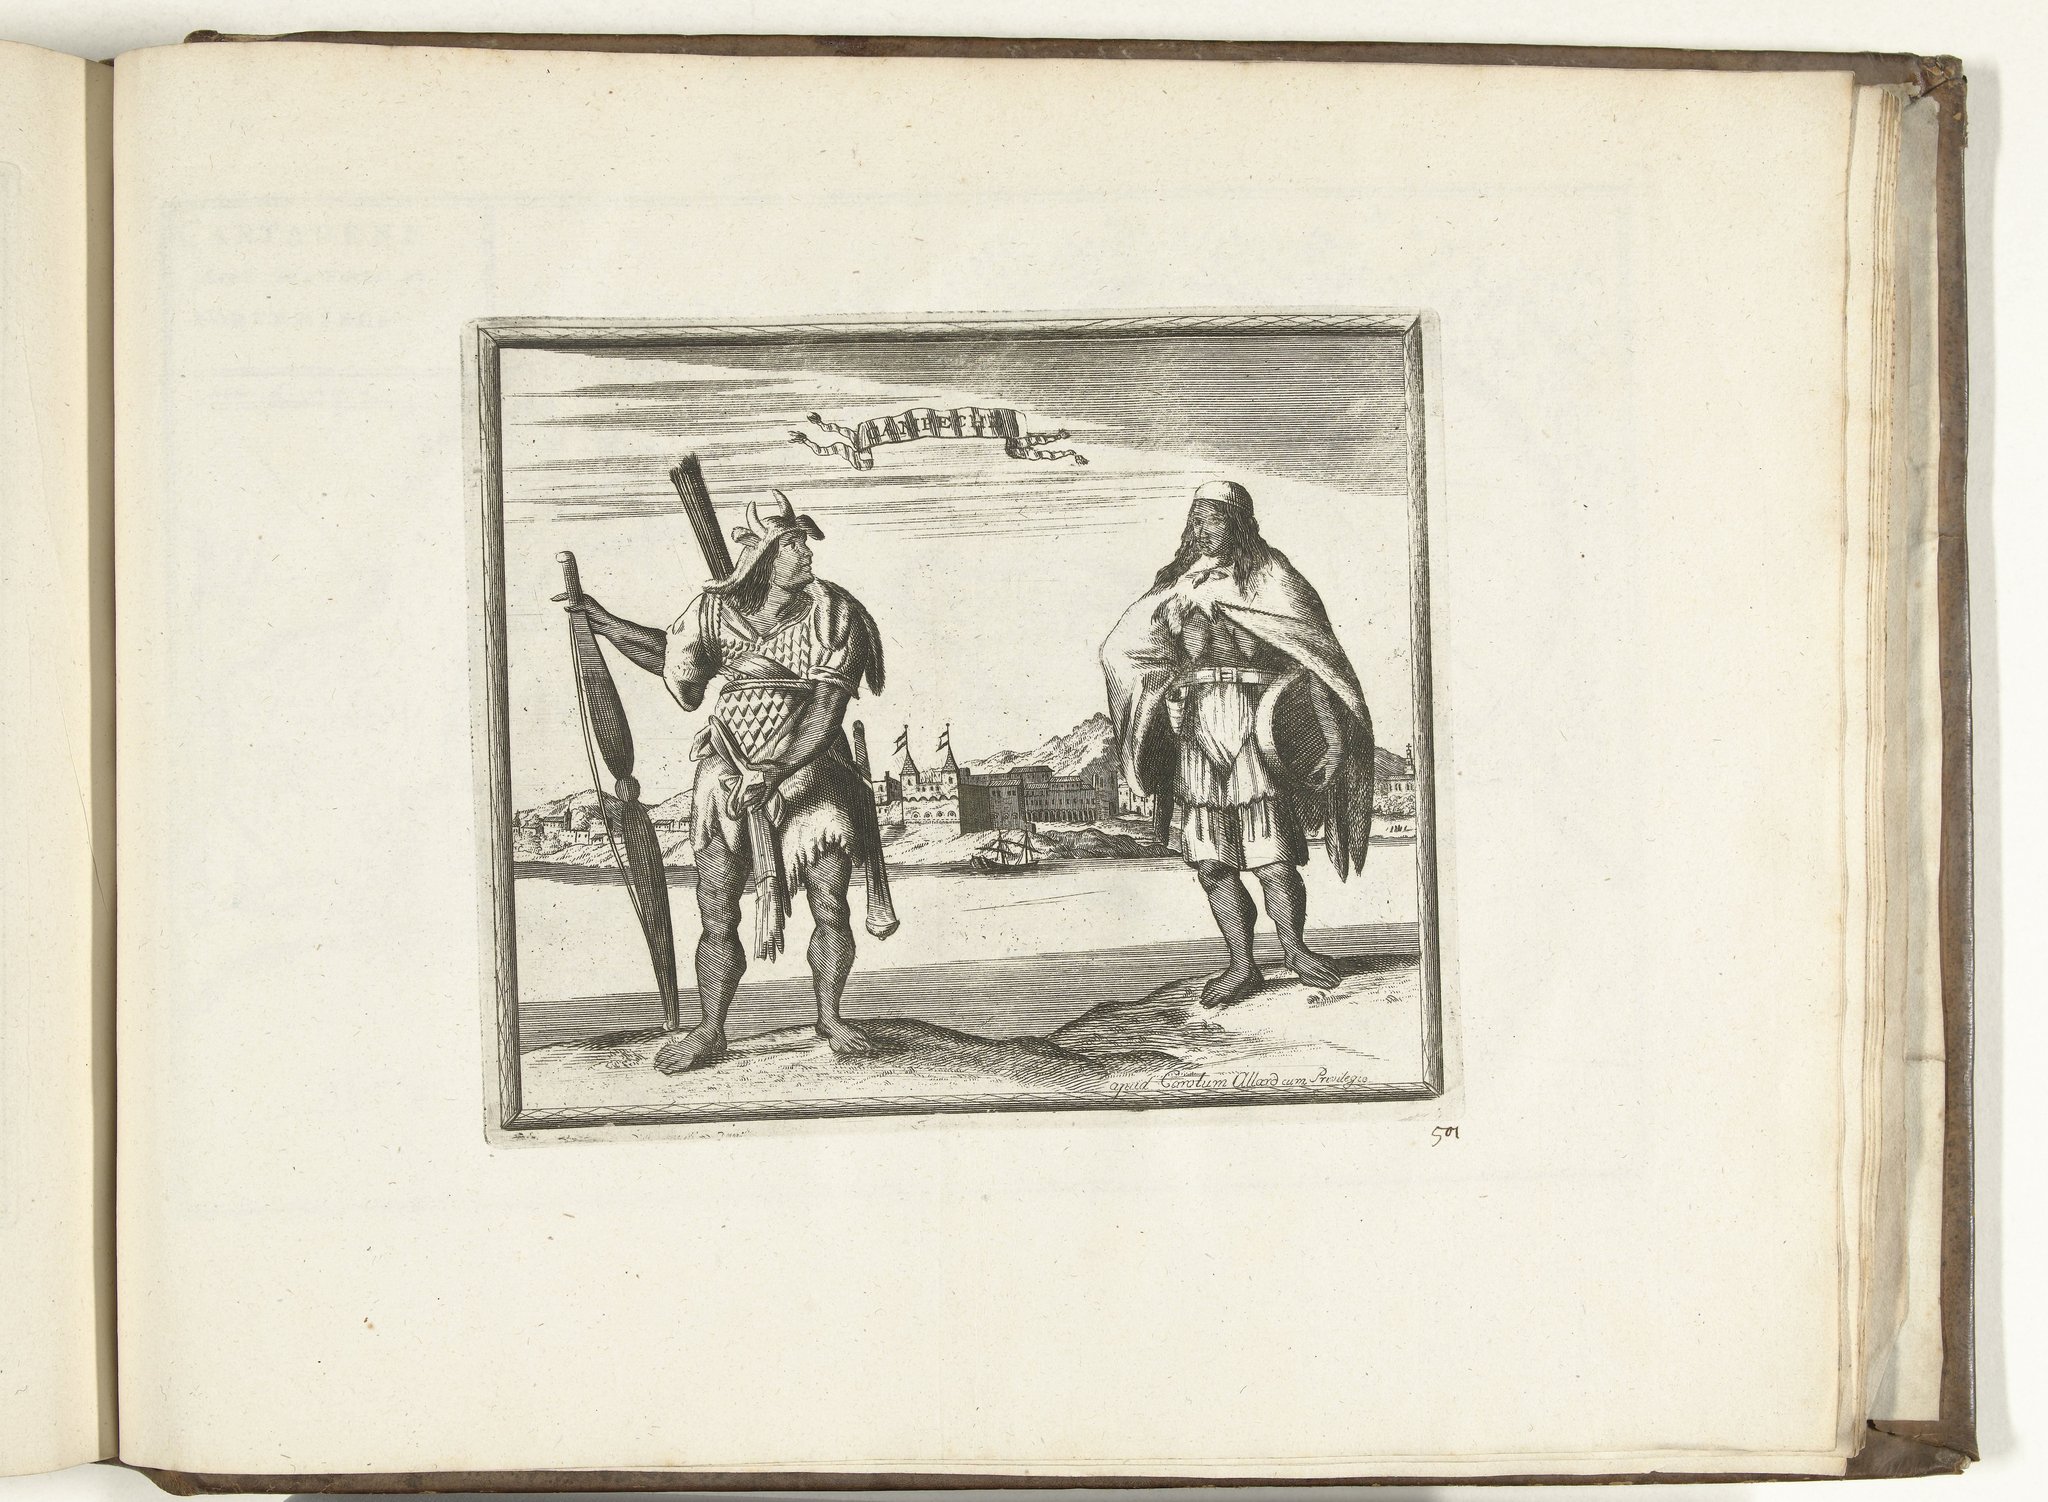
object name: costume print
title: Les Forces de l'Europe, Asie, Afrique et Amerique (...) Comme aussi les Cartes des Côtes de France et d'Espagne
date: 1726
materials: paper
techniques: engraving, etching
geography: amsterdam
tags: folk costume, regional costume, indigenous peoples of central america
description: Man en vrouw van Campeche in Yucatan in Mexico, gekleed volgens de lokale dracht, op de achtergrond de stad. Plaat nr. 501 in deel XX van het prentwerk: Les Forces de l'Europe, Asie, Afrique et Amerique ... Comme aussi les Cartes des Côtes de France et d'Espagne uit 1726, dit tweede deel met 271 met de hand genummerde platen van vermaarde sterke steden en vestingen in het kader van de Spaanse Successieoorlog 1701-1713. Voor het merendeel zijn deze platen gekopieerd naar de anonieme Franse platen van vermaarde sterke steden en vestingen: in Les forces de l'Europe en in: Le theatre de la guerre, dans les Pays-Bas, beide oorspronkelijk uitgegeven door Nicolas de Fer te Parijs (1693-1697) in het kader van de Negenjarige Oorlog.